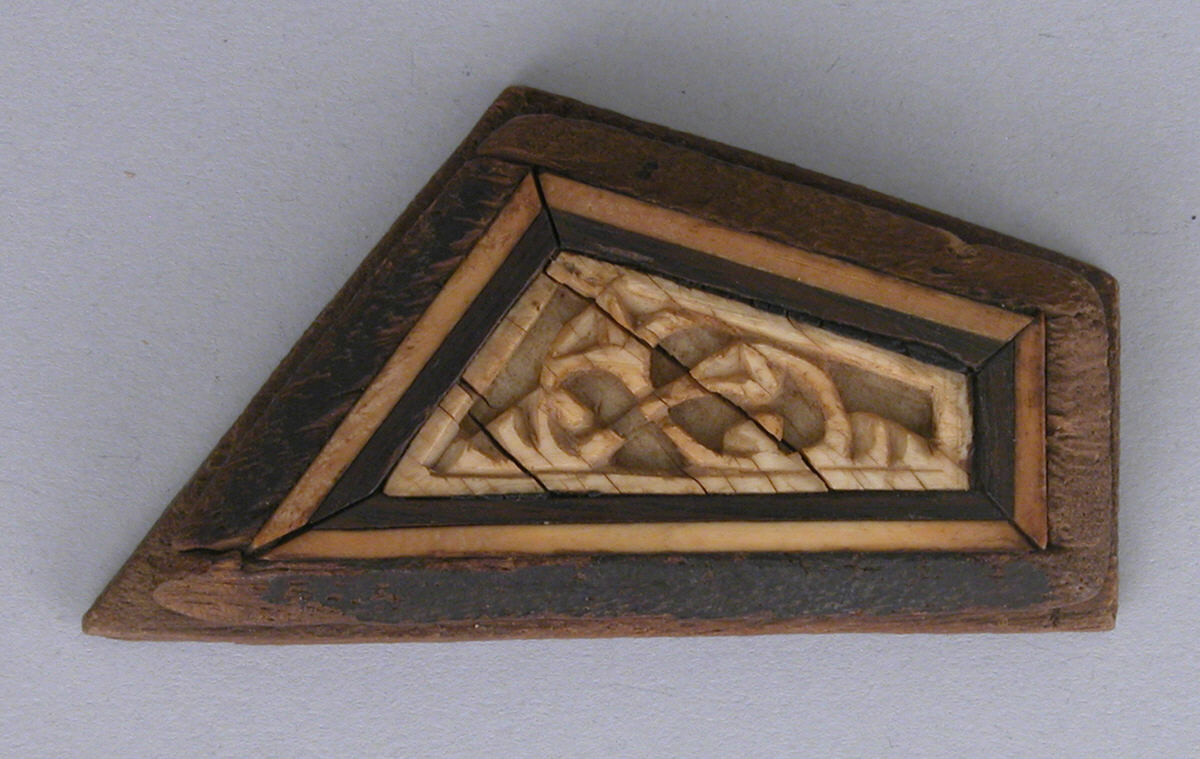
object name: panel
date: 1201-1300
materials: ivory, wood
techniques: carving, inlay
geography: egypt